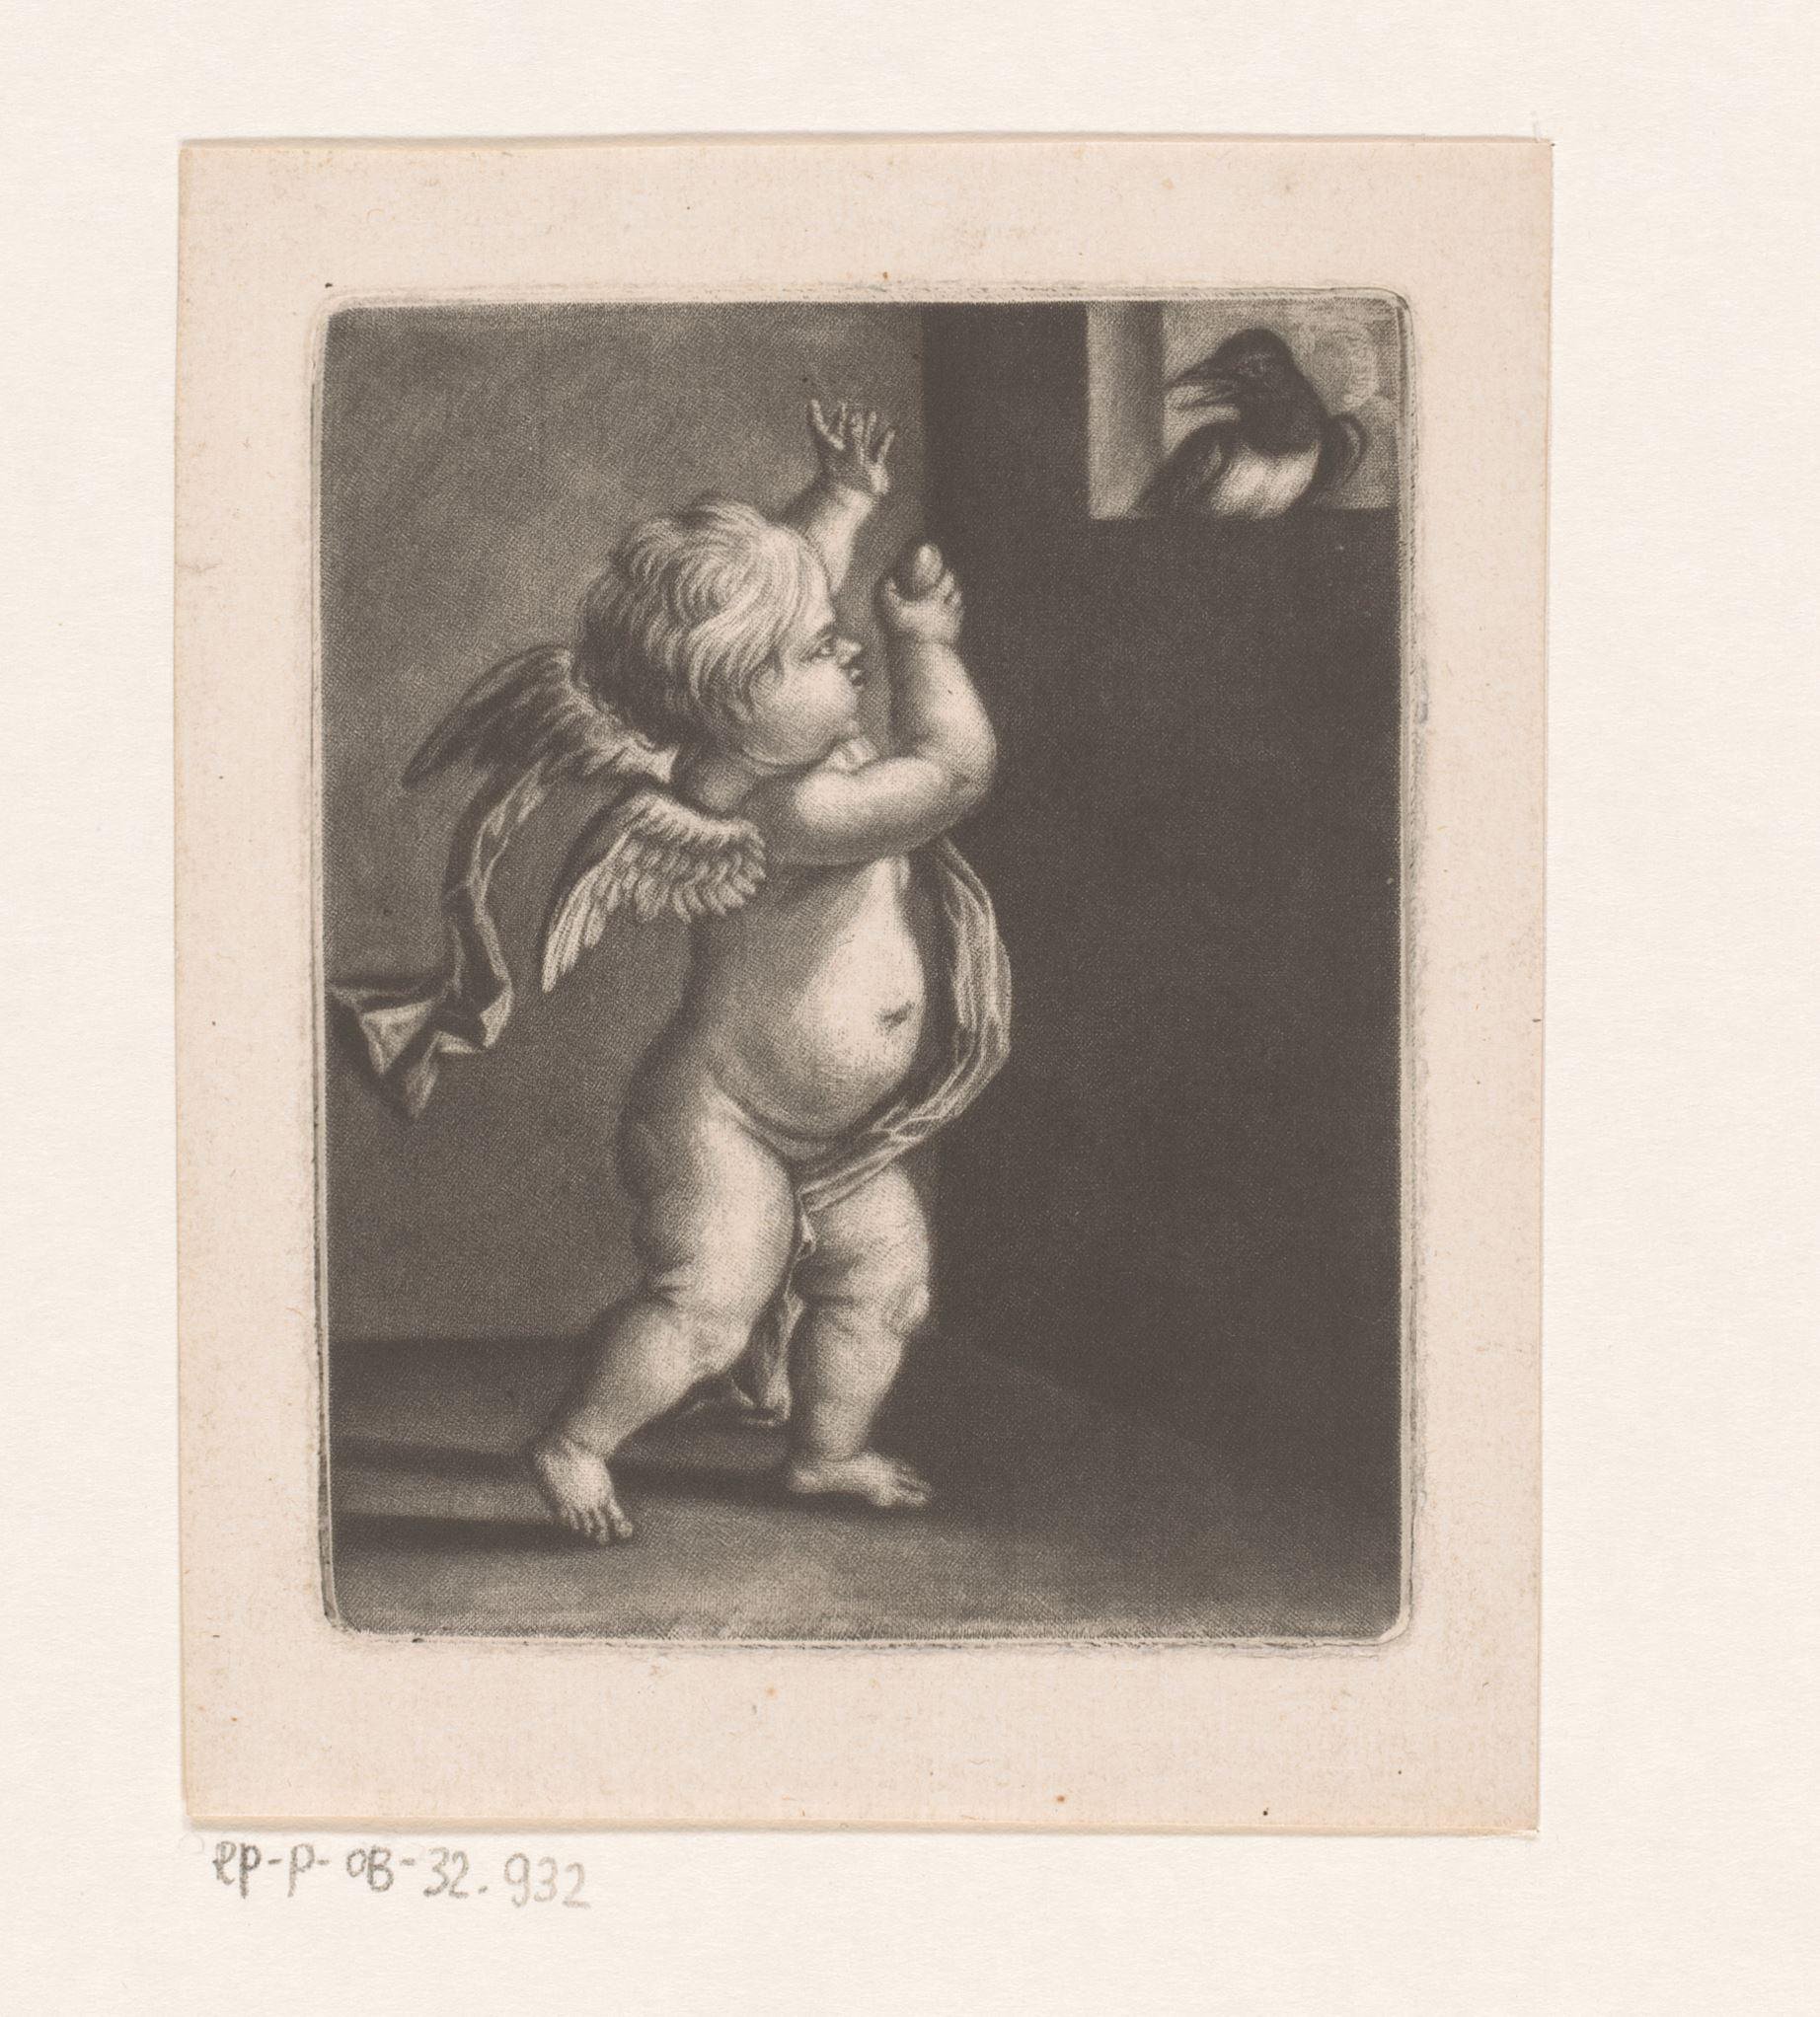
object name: print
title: Cupido met een ei en ekster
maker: john smith (prentmaker/ uitgever)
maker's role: print maker, publisher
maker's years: 1652-1743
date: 1662-1742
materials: paper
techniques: mezzotint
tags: child robbing bird's nests, (story of) cupid, amor (eros), song-birds: magpie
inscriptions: collector's mark: Lugt 240